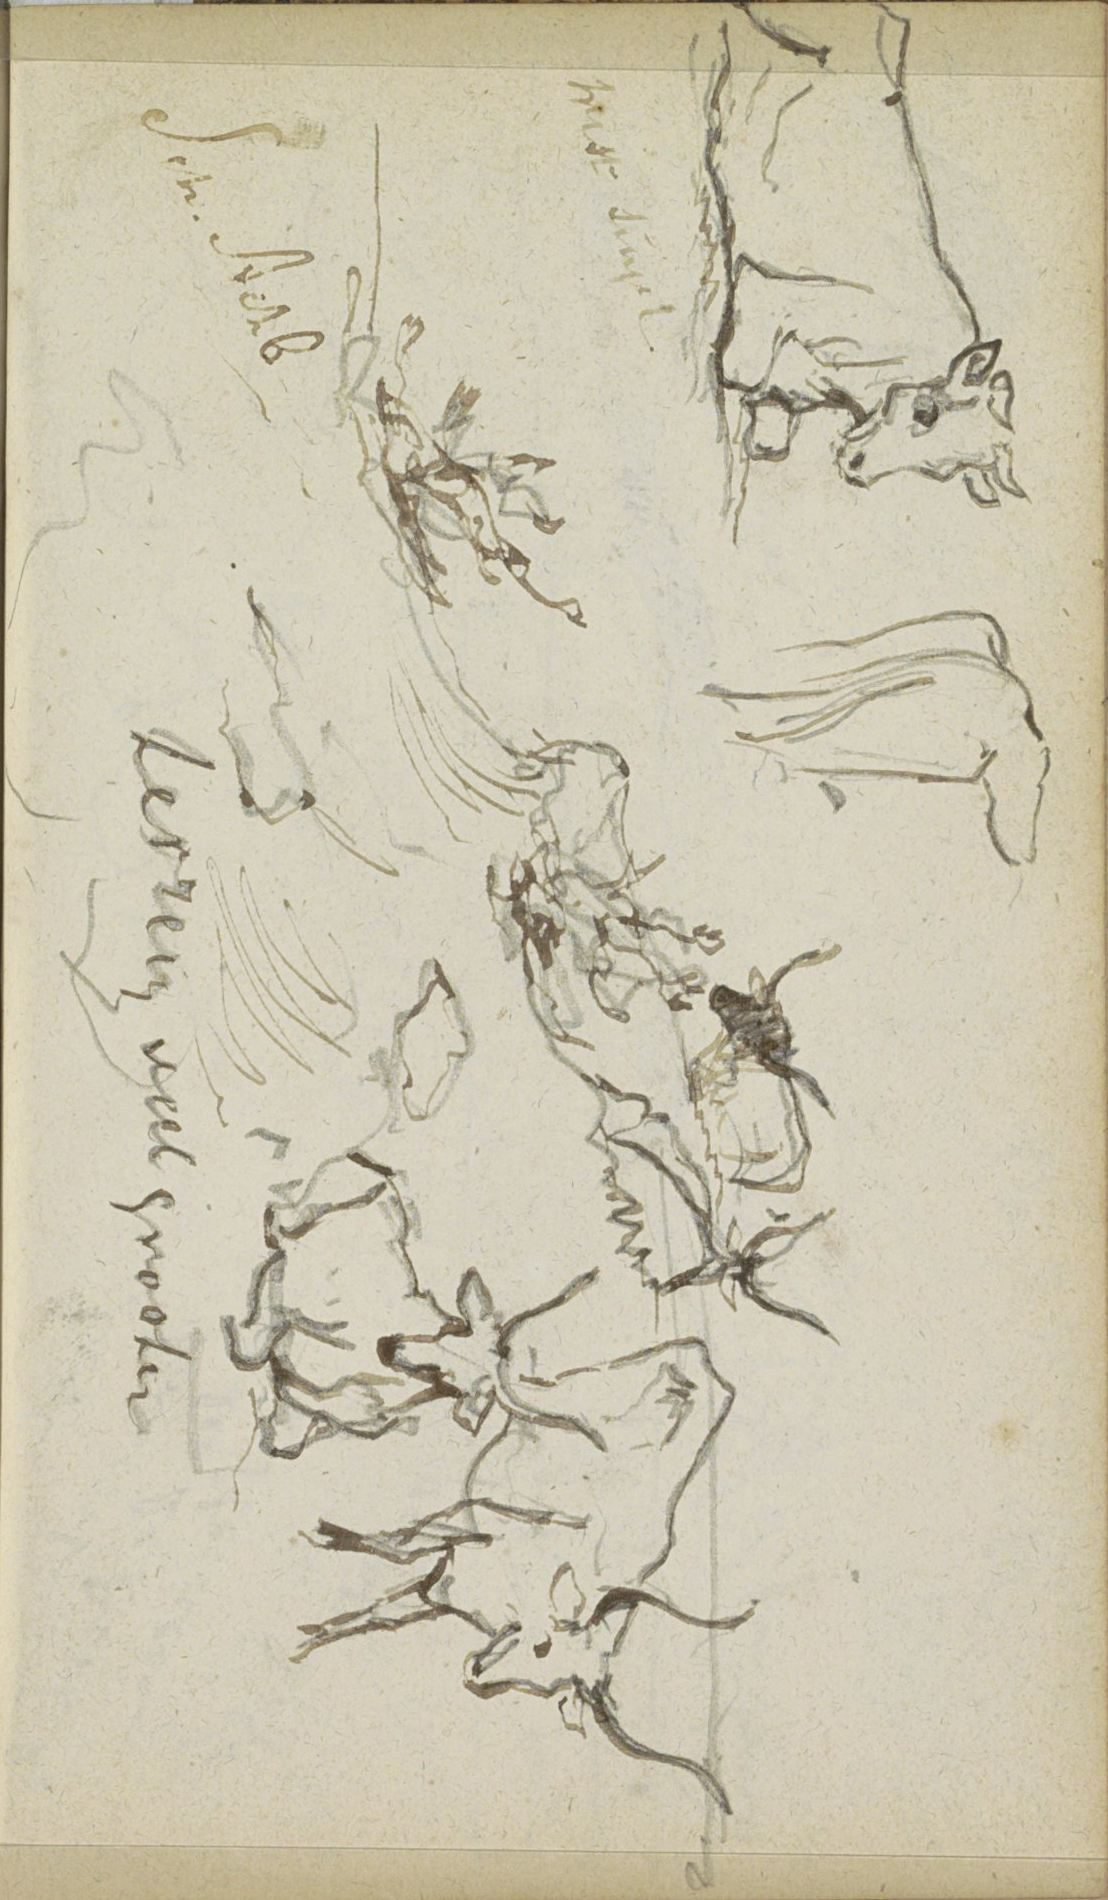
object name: sketchbook leaf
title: Koeien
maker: johannes tavenraat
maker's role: draughtsman, painter, print maker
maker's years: 1809-1881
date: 1854-1868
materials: ink, paper, pencil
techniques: pen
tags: cow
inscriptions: kleurnotitie, handgeschreven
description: Blad 77 recto uit een schetsboek met 88 bladen.